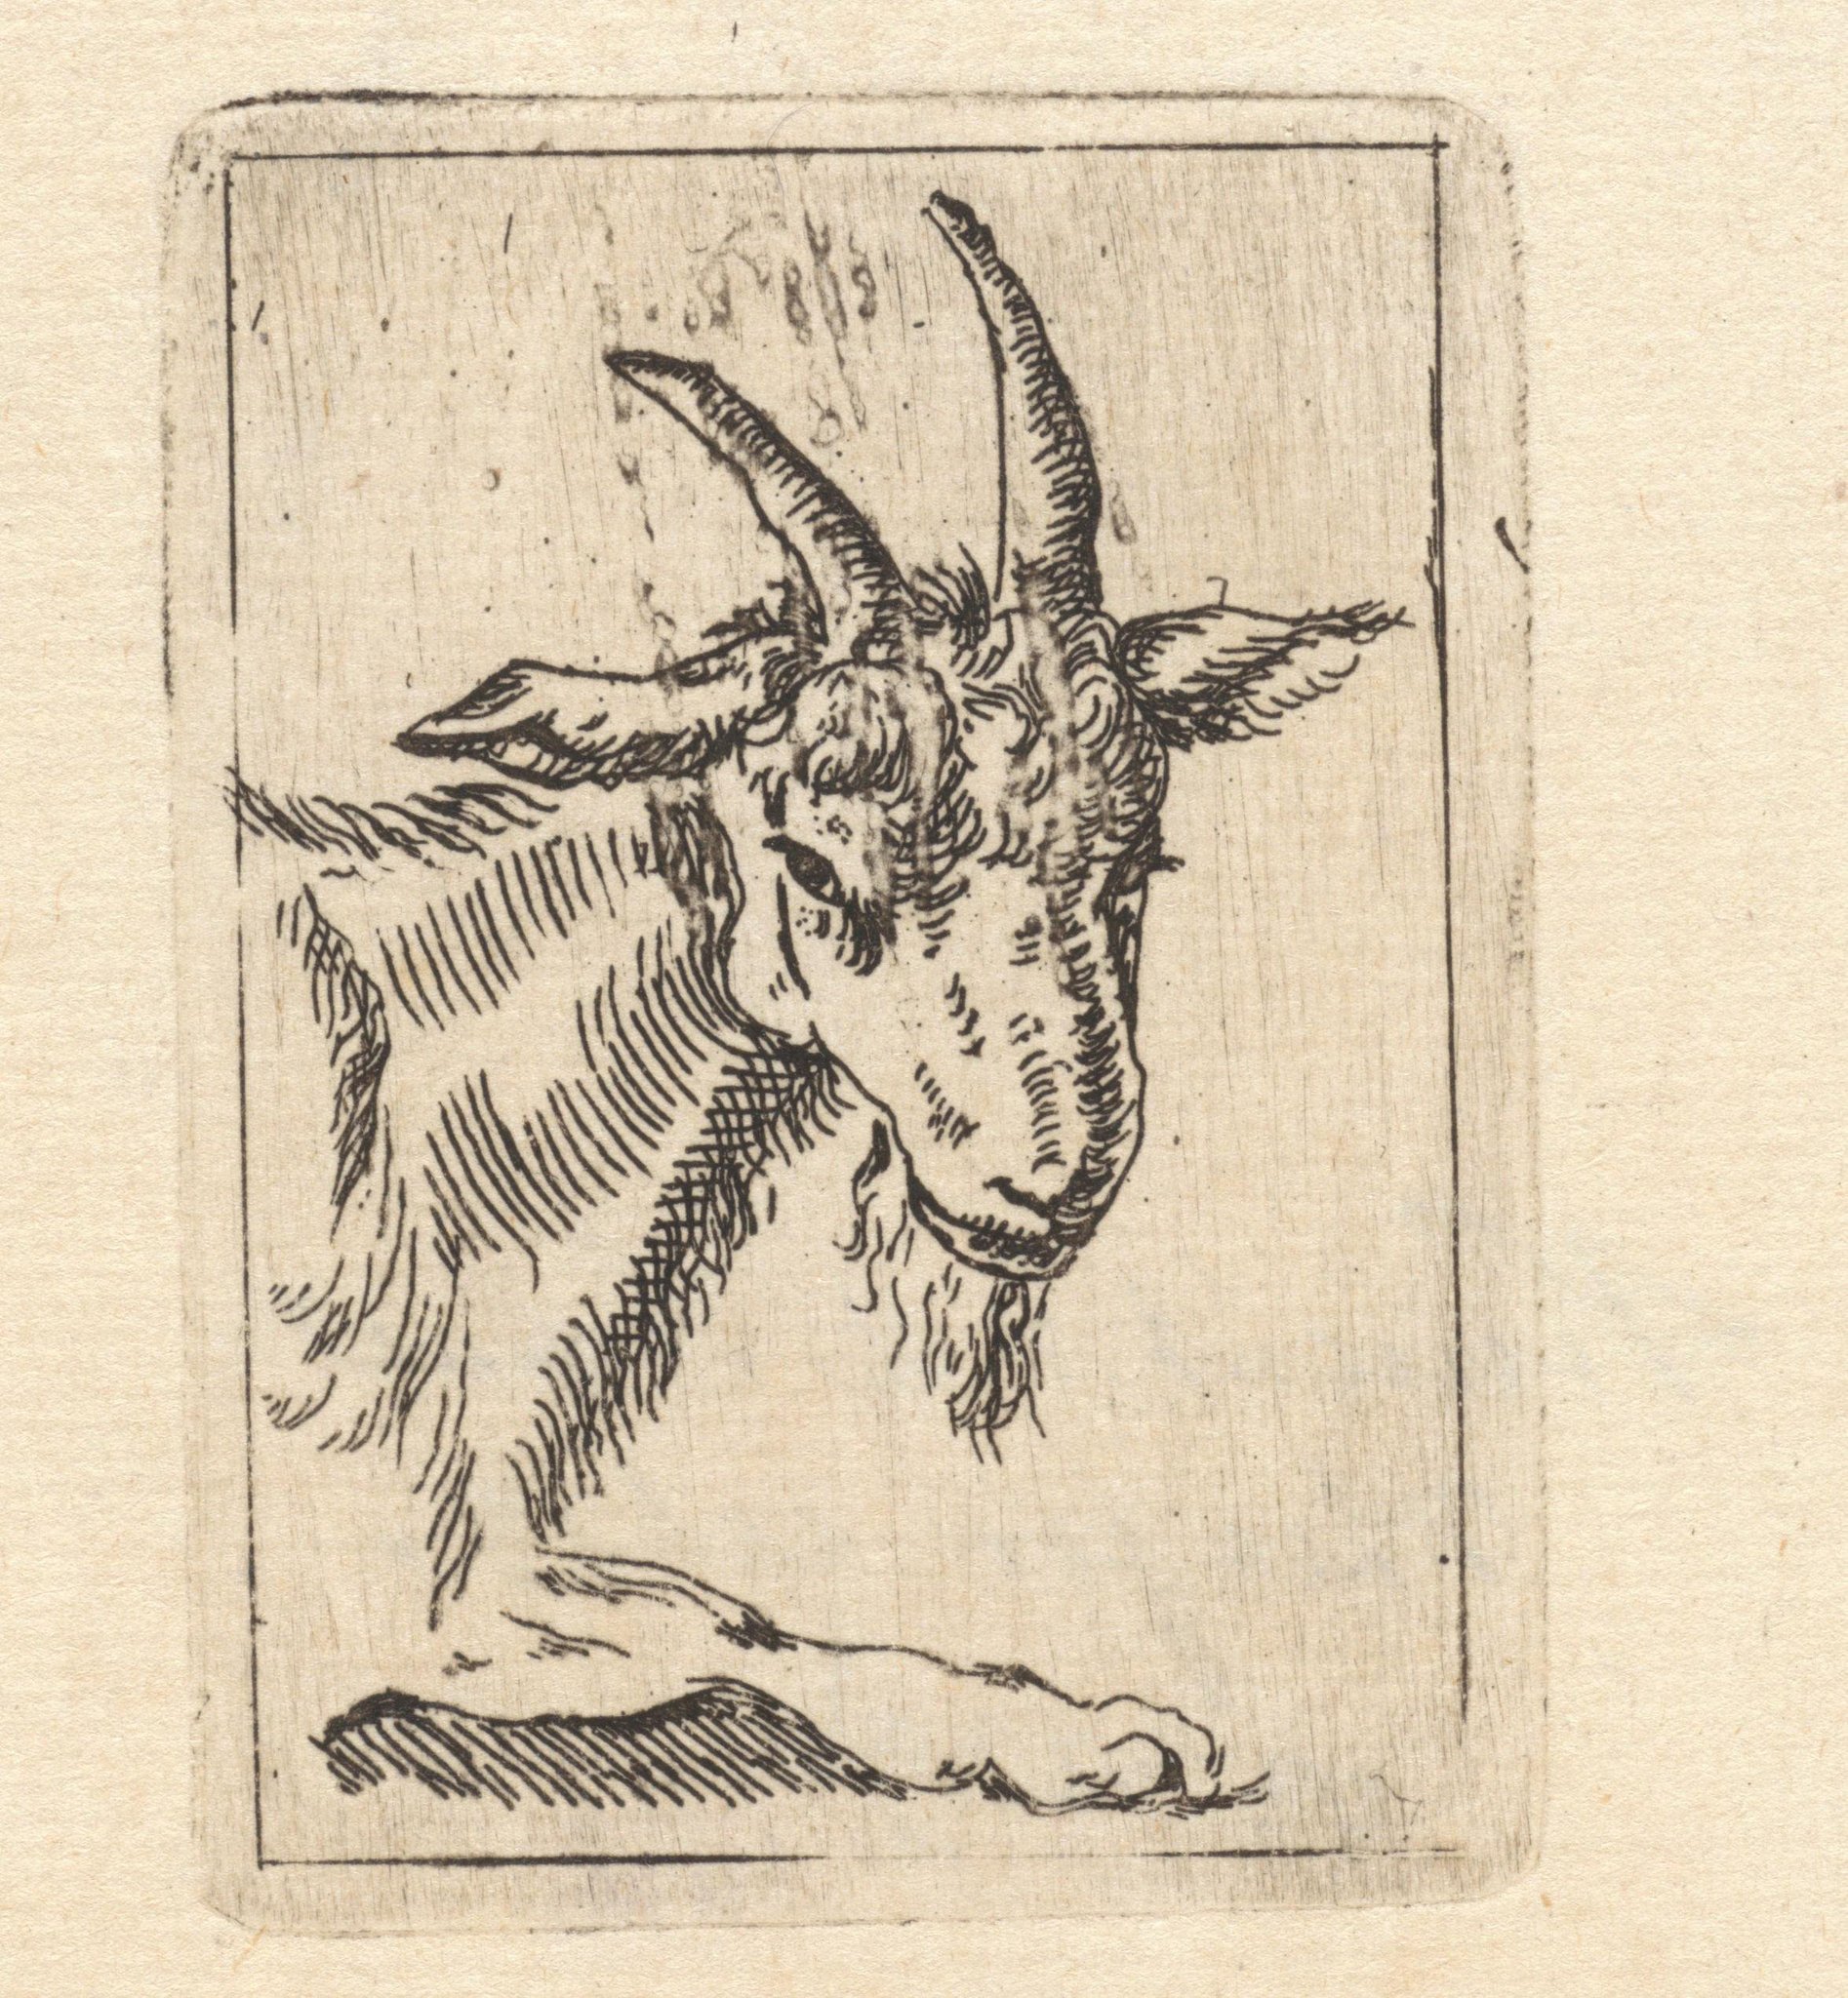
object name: print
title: Kop van een geit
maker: vincent van der vinne van lee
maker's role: print maker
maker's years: 1798-1876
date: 1808-1876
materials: paper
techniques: etching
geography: netherlands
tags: goat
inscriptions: collector's mark: Lugt 2227